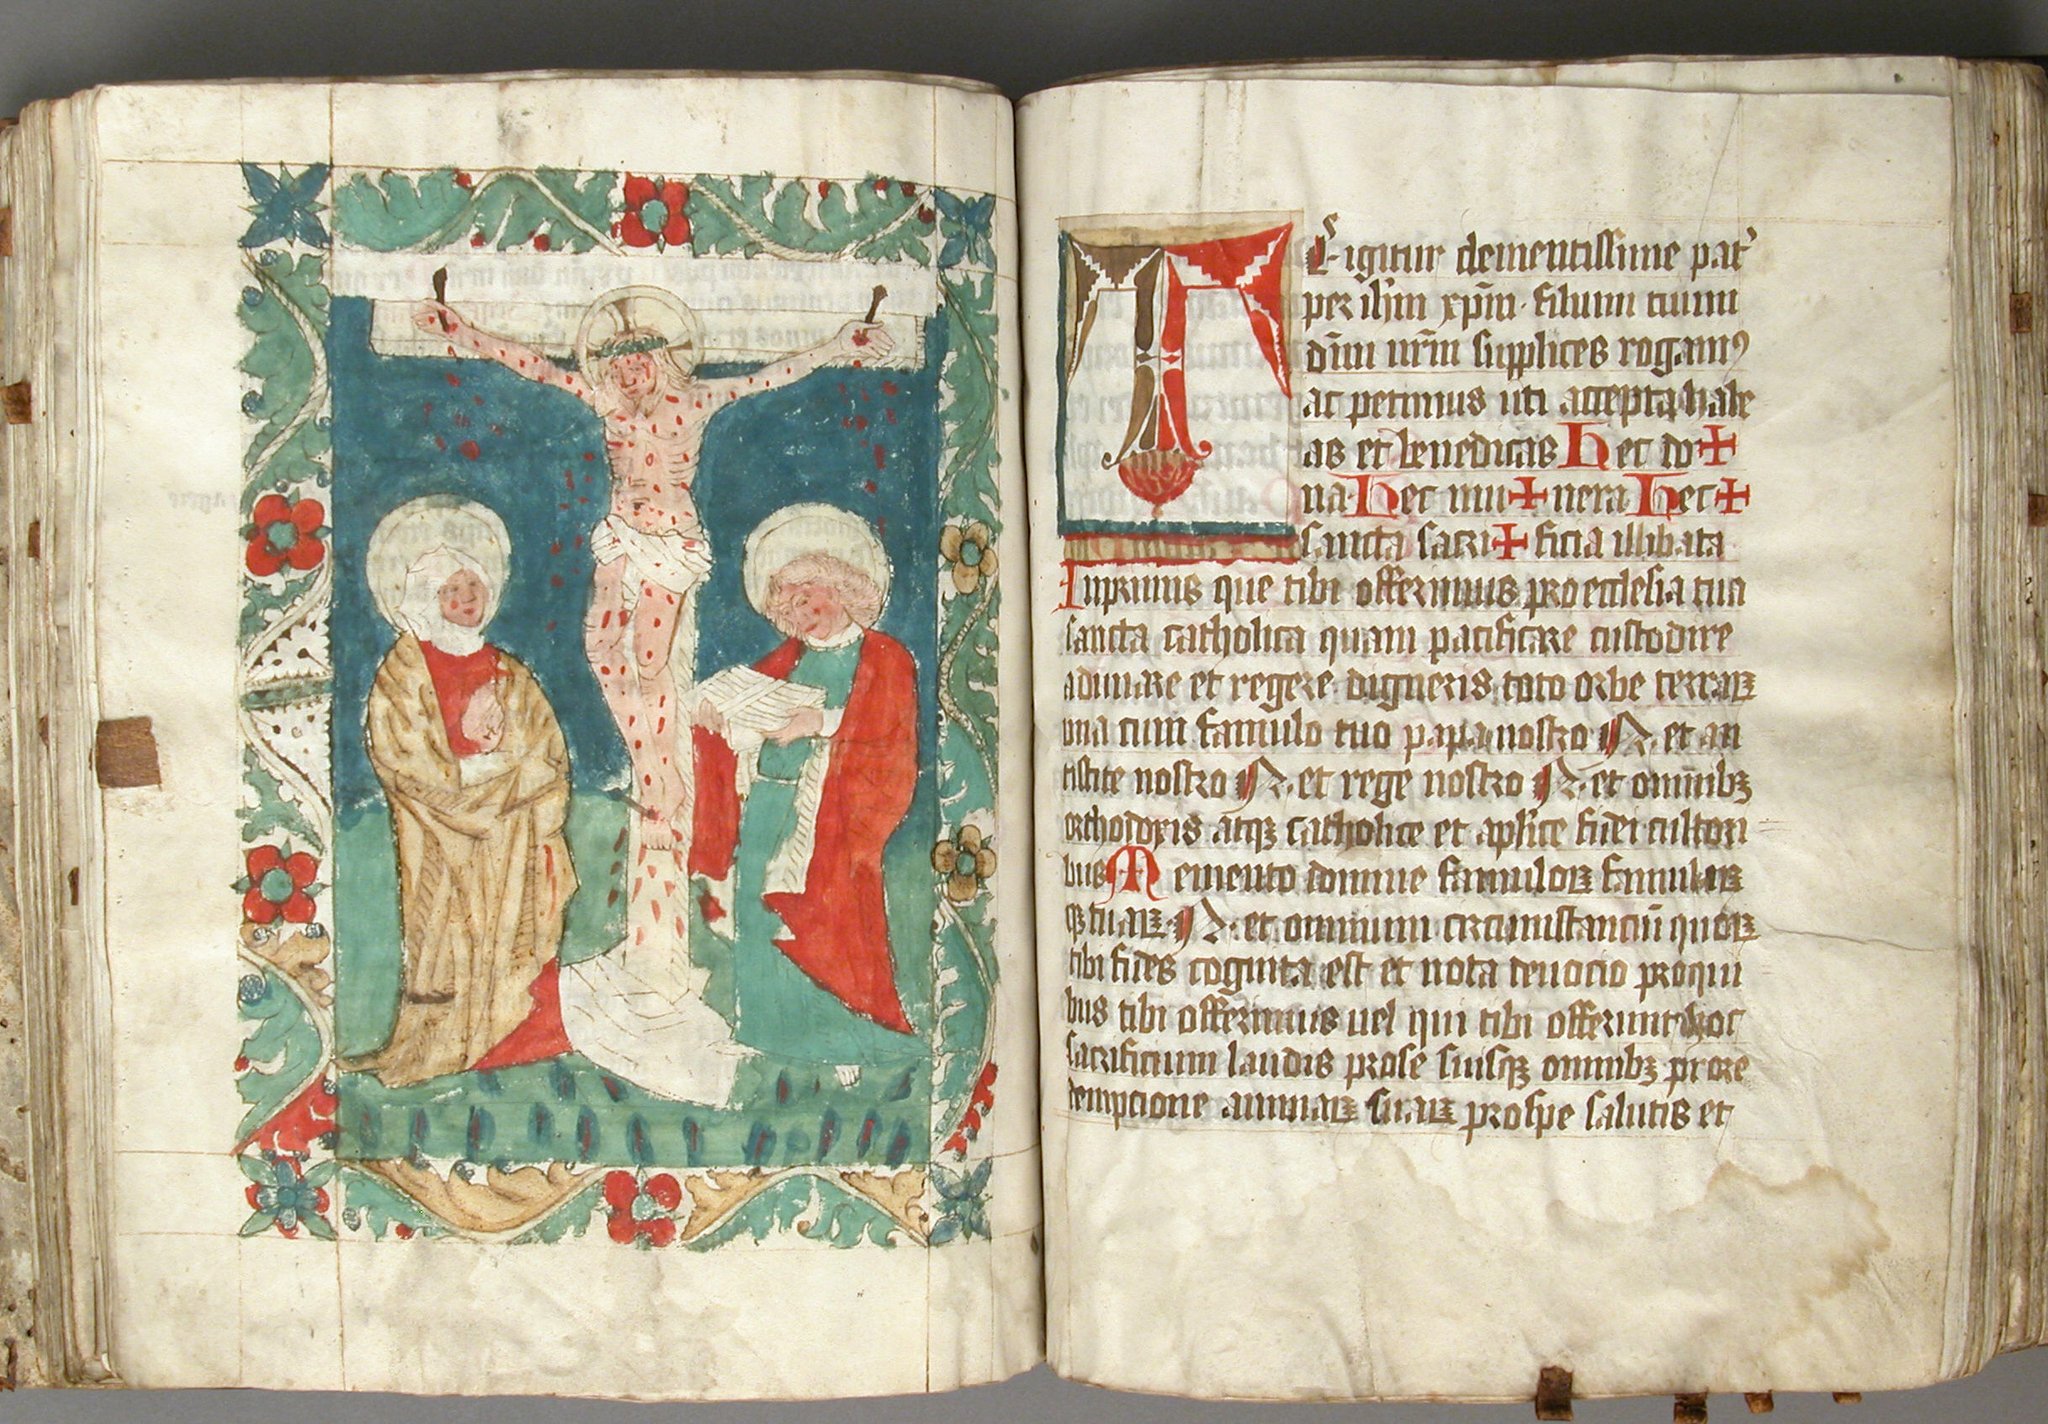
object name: missal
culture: german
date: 1401-1500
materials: ink, parchment, paint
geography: germany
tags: christ,virgin mary,crucifixion